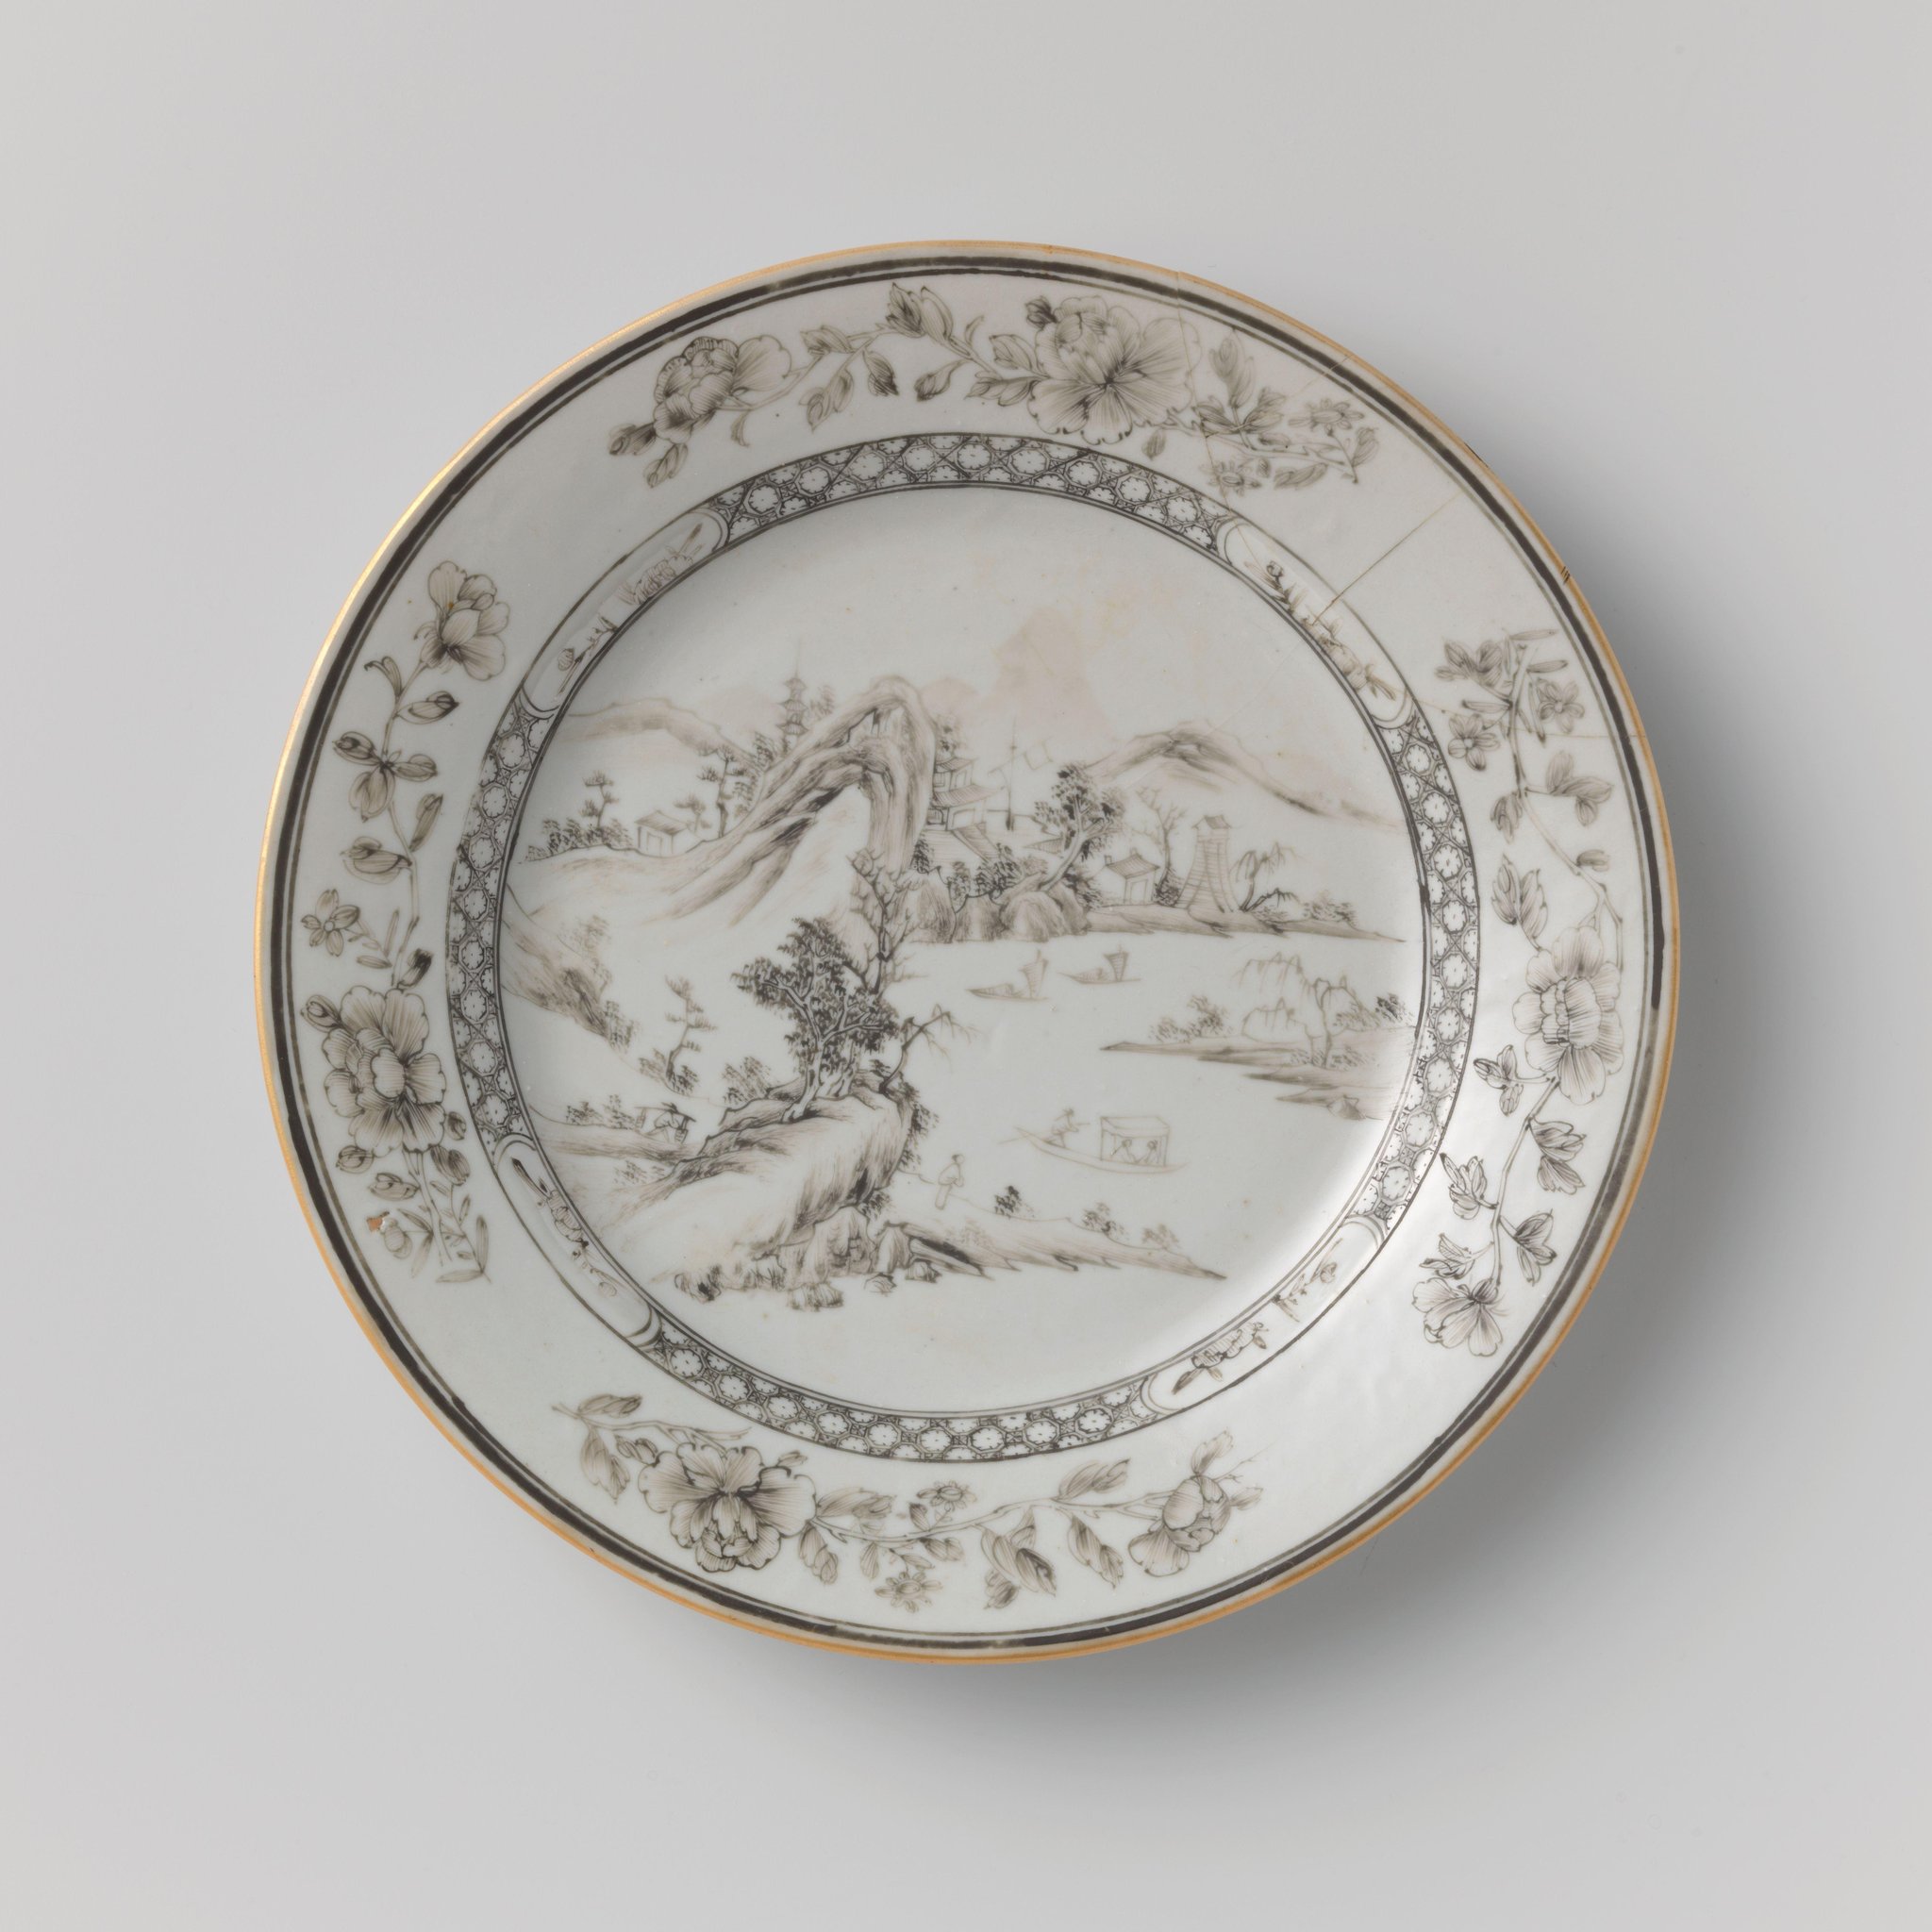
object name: plate dish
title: Plate with a riverlandscape and flower sprays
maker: Anonymous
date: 1725-1749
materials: glaze, gold, paint, porcelain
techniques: firing, gilding, turning, vitrification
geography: china